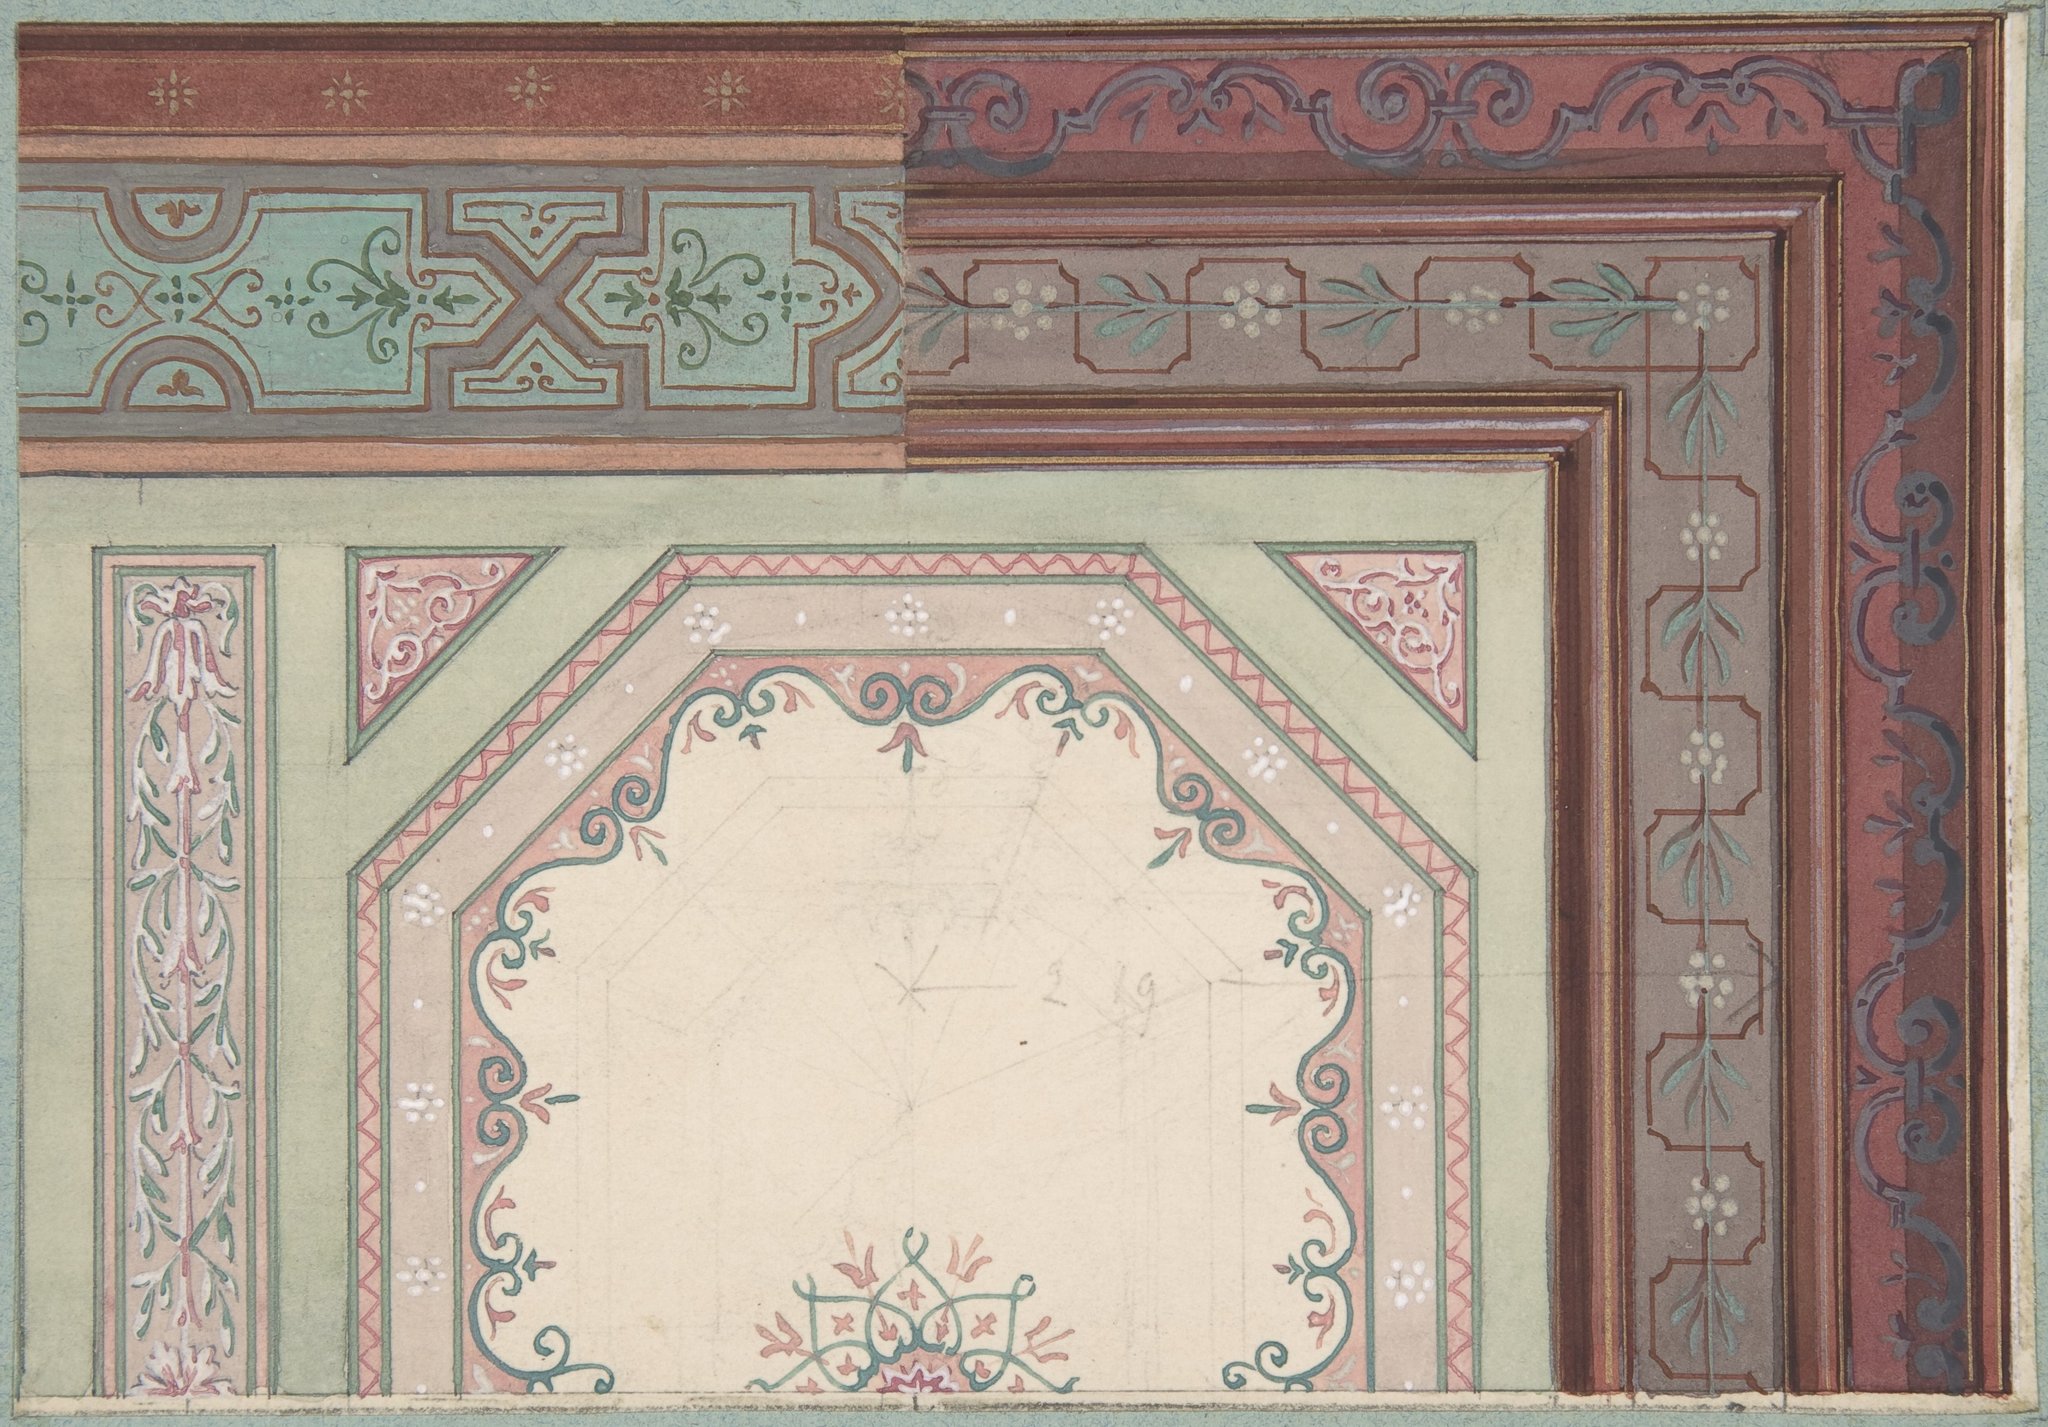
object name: drawing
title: Ceiling design, Castle Blayney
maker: jules-edmond-charles lachaise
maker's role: artist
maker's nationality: french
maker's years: 1897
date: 1851-1900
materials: gilt, gouache, watercolor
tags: ceilings